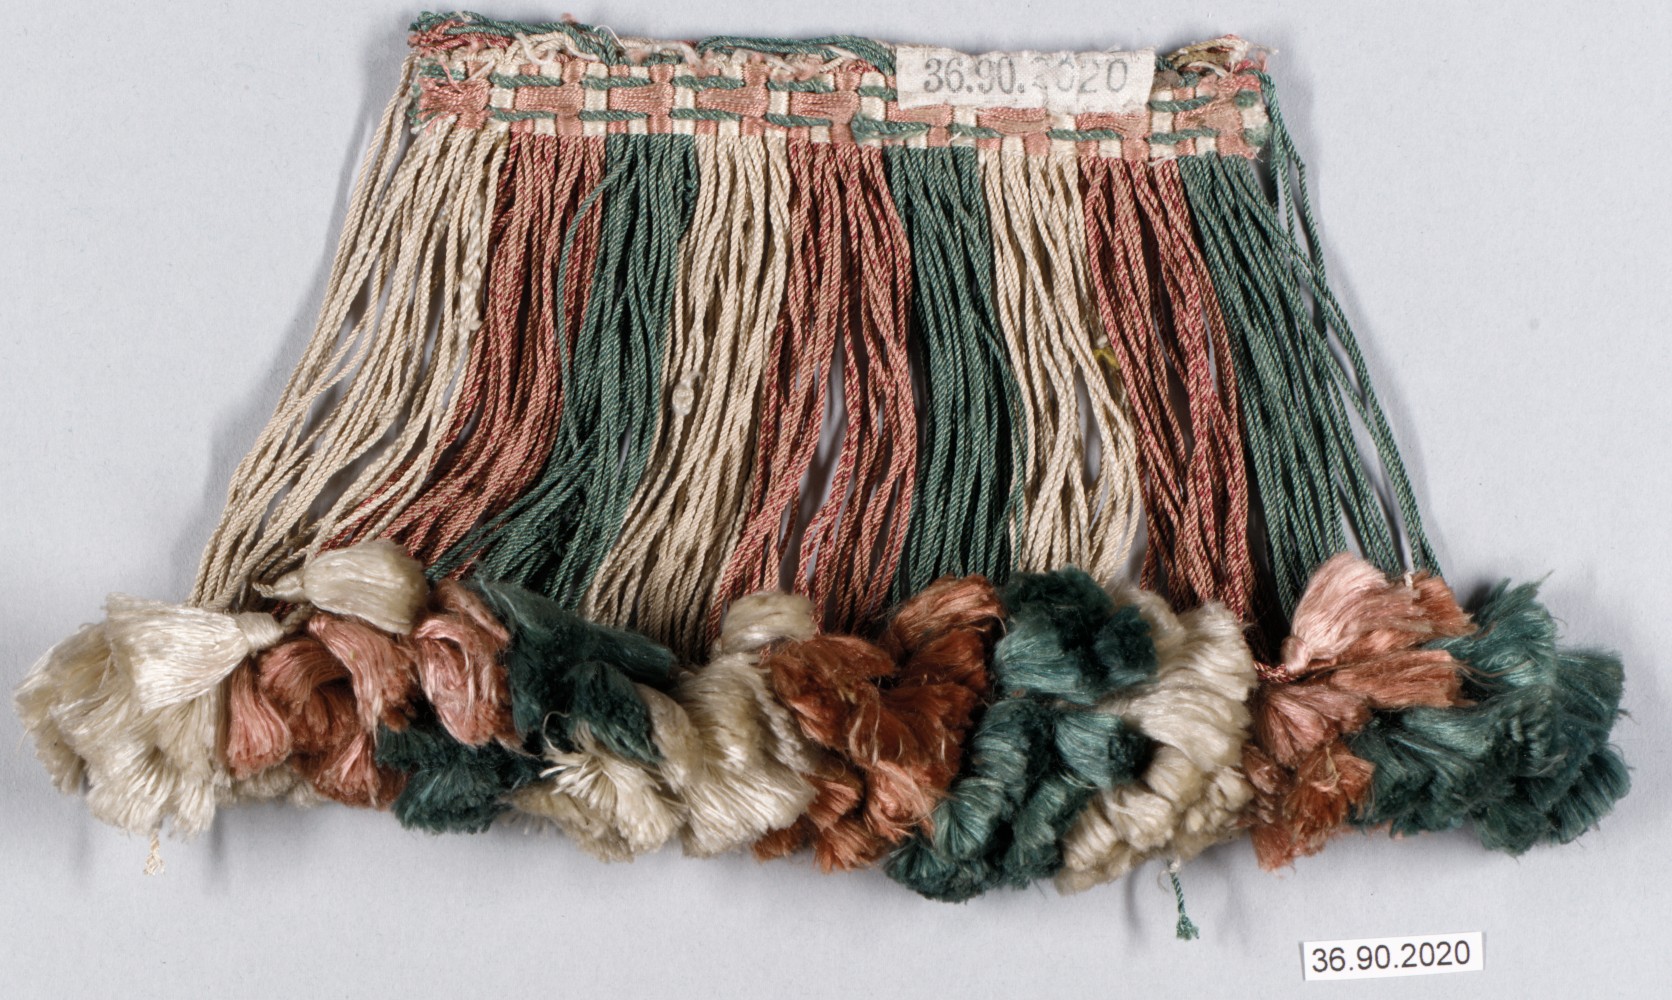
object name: fringe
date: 1775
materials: silk